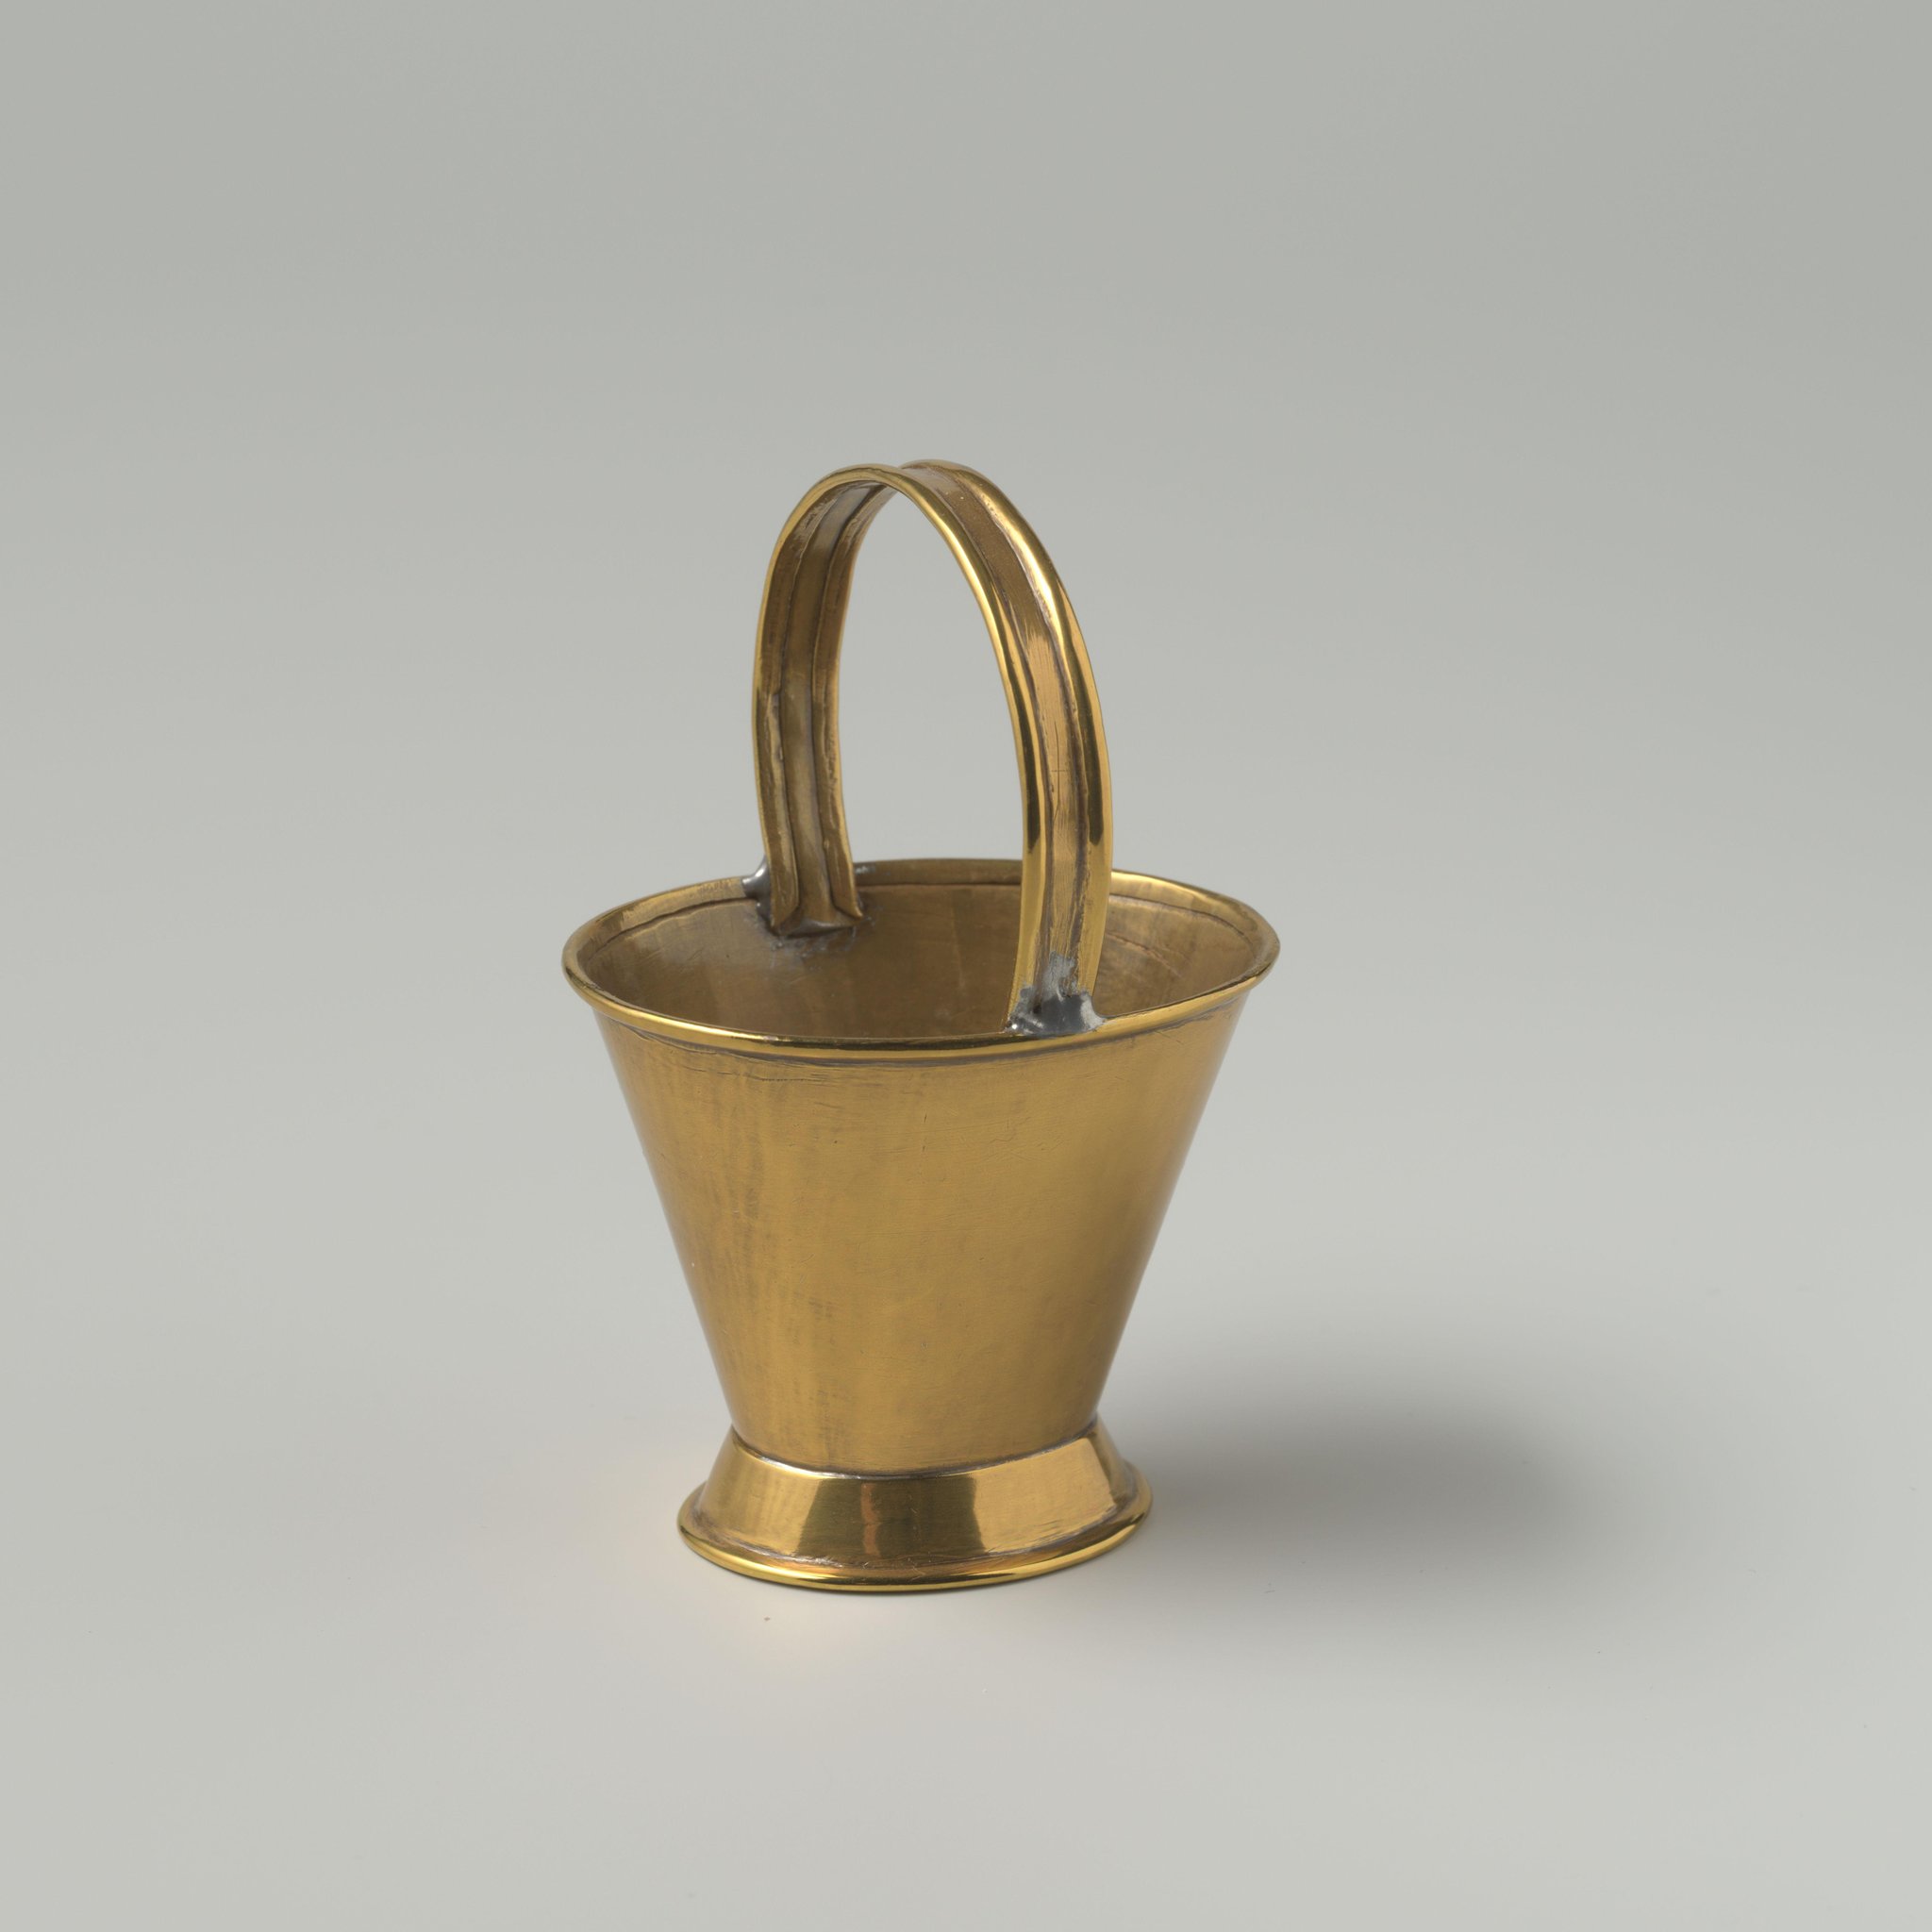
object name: miniature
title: Marktemmer van geel koper; ovale, wijd uitlopende hoge bak met vast hengsel, op breed uitlopende standring, alle randen zijn naar binnen omgeslagen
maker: Anonymous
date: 1690-1710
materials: copper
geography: amsterdam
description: Marktemmer van geel koper; ovale, wijduitlopende hoge bak met vast hengsel, op breed uitlopende standring. Alle randen zijn naar binnen omgeslagen.